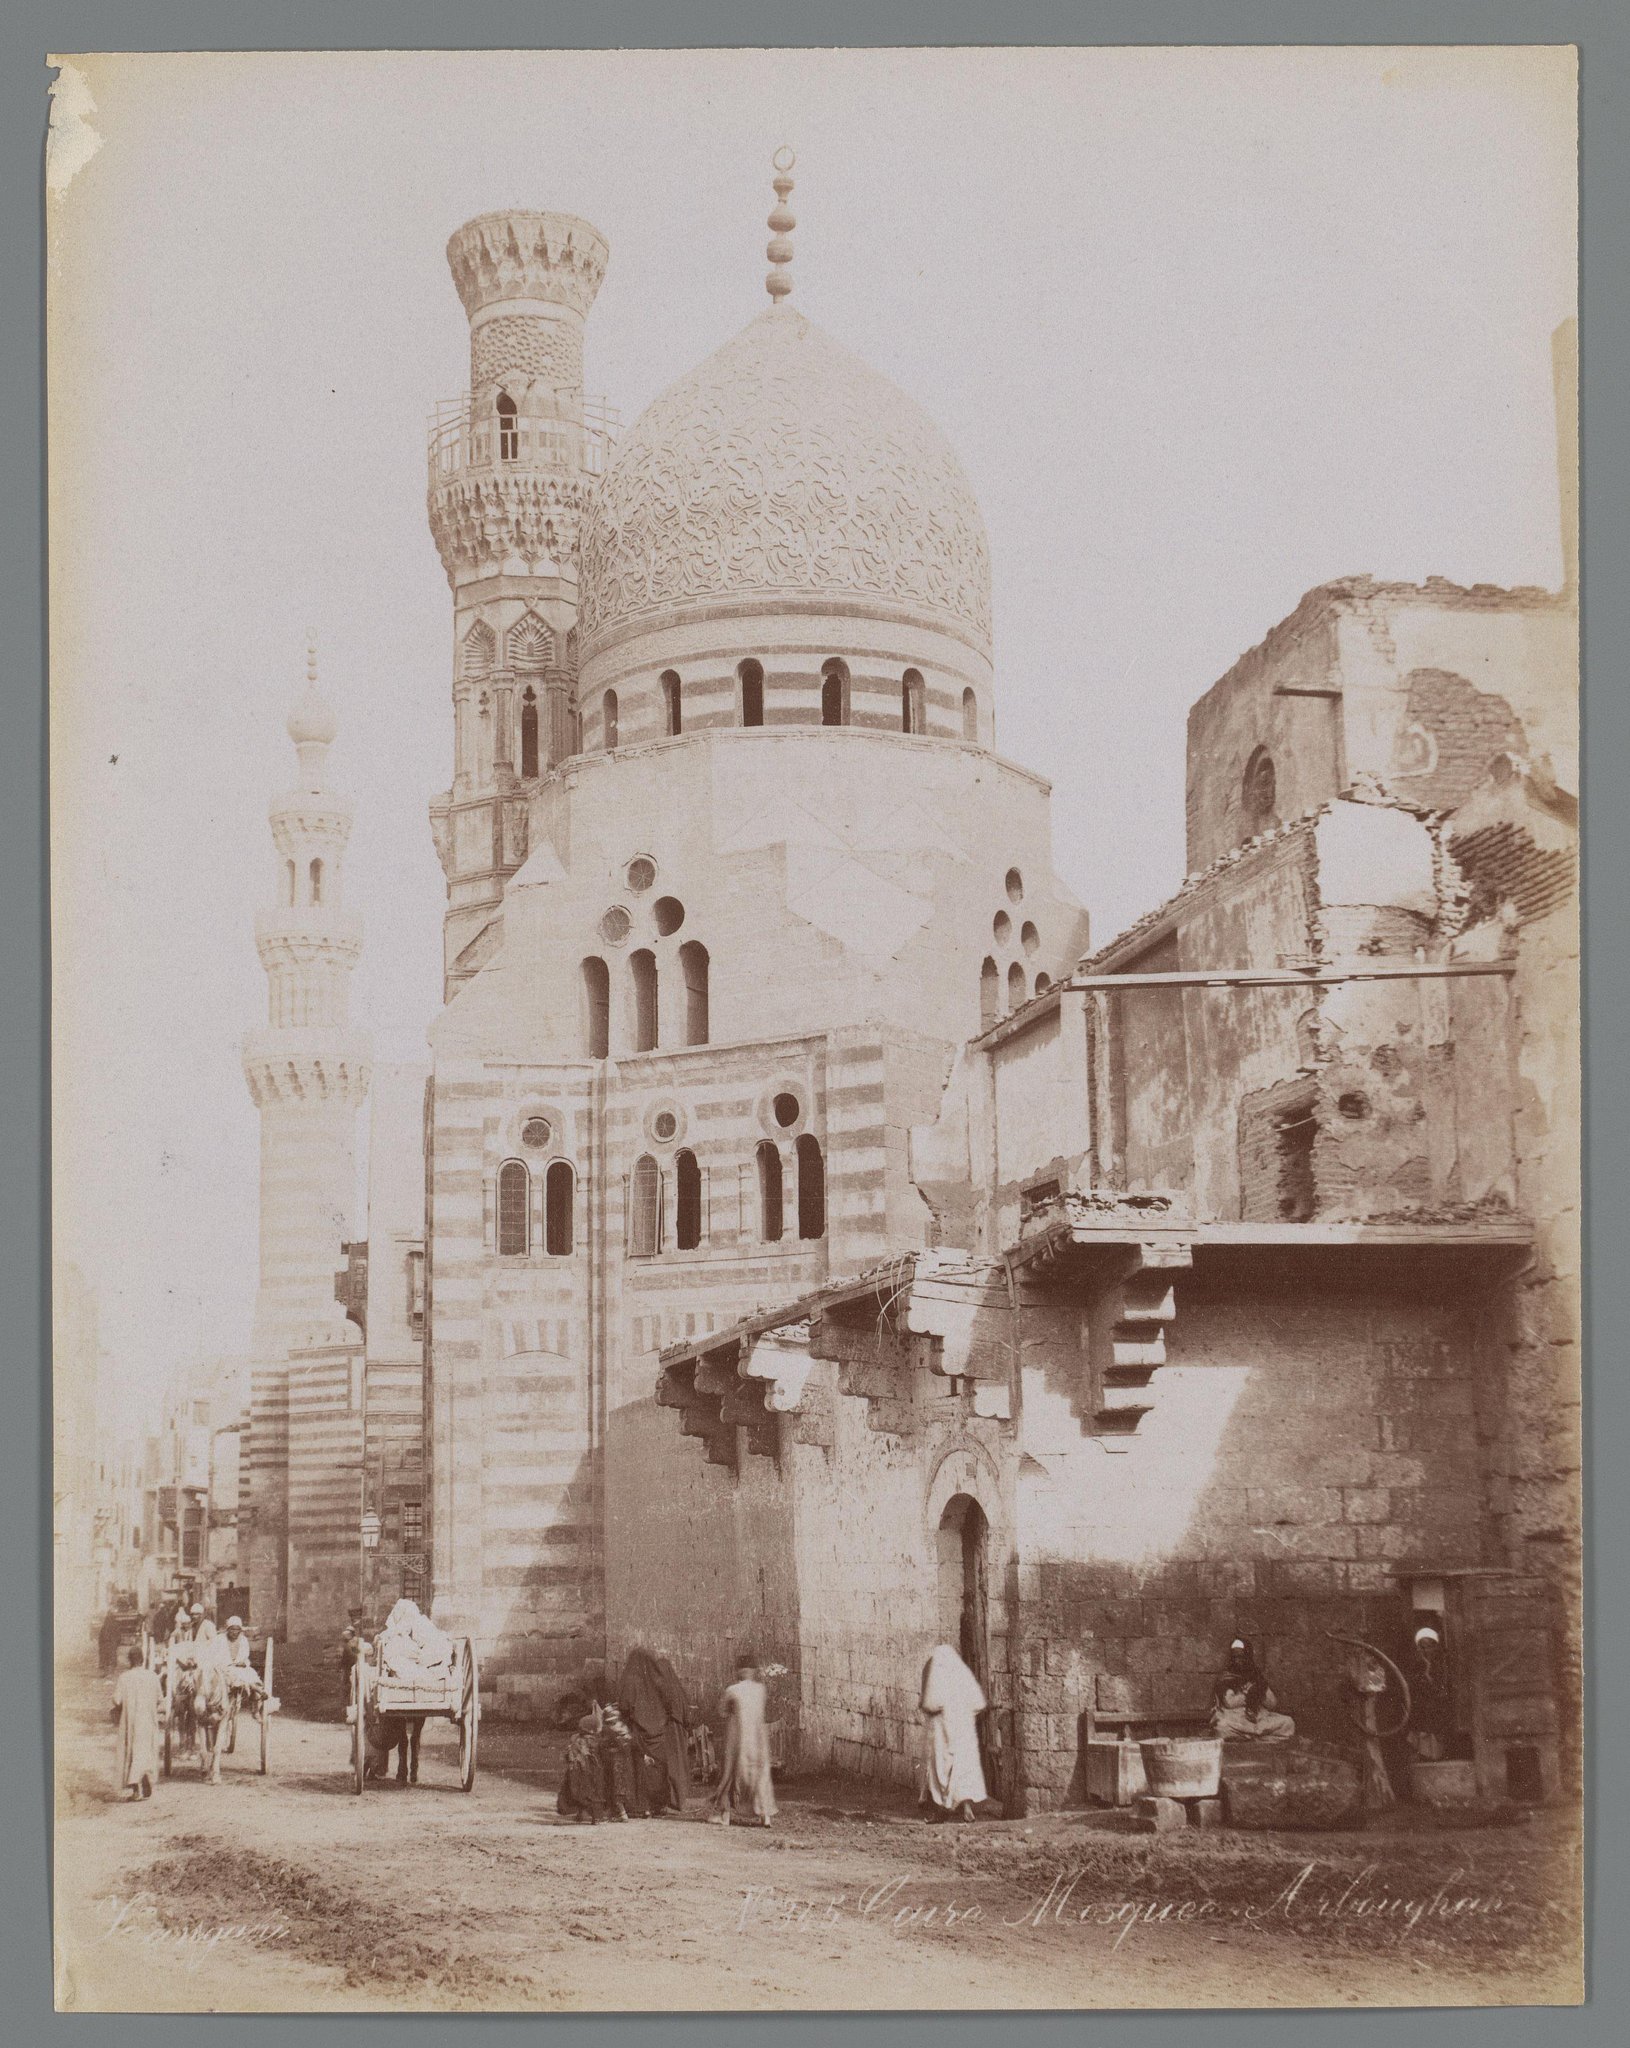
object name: photograph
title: Caire Mosquee Arboughak [?]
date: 1870-1910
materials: paper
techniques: albumen print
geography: cairo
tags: necropolis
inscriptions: number: ‘No 345’